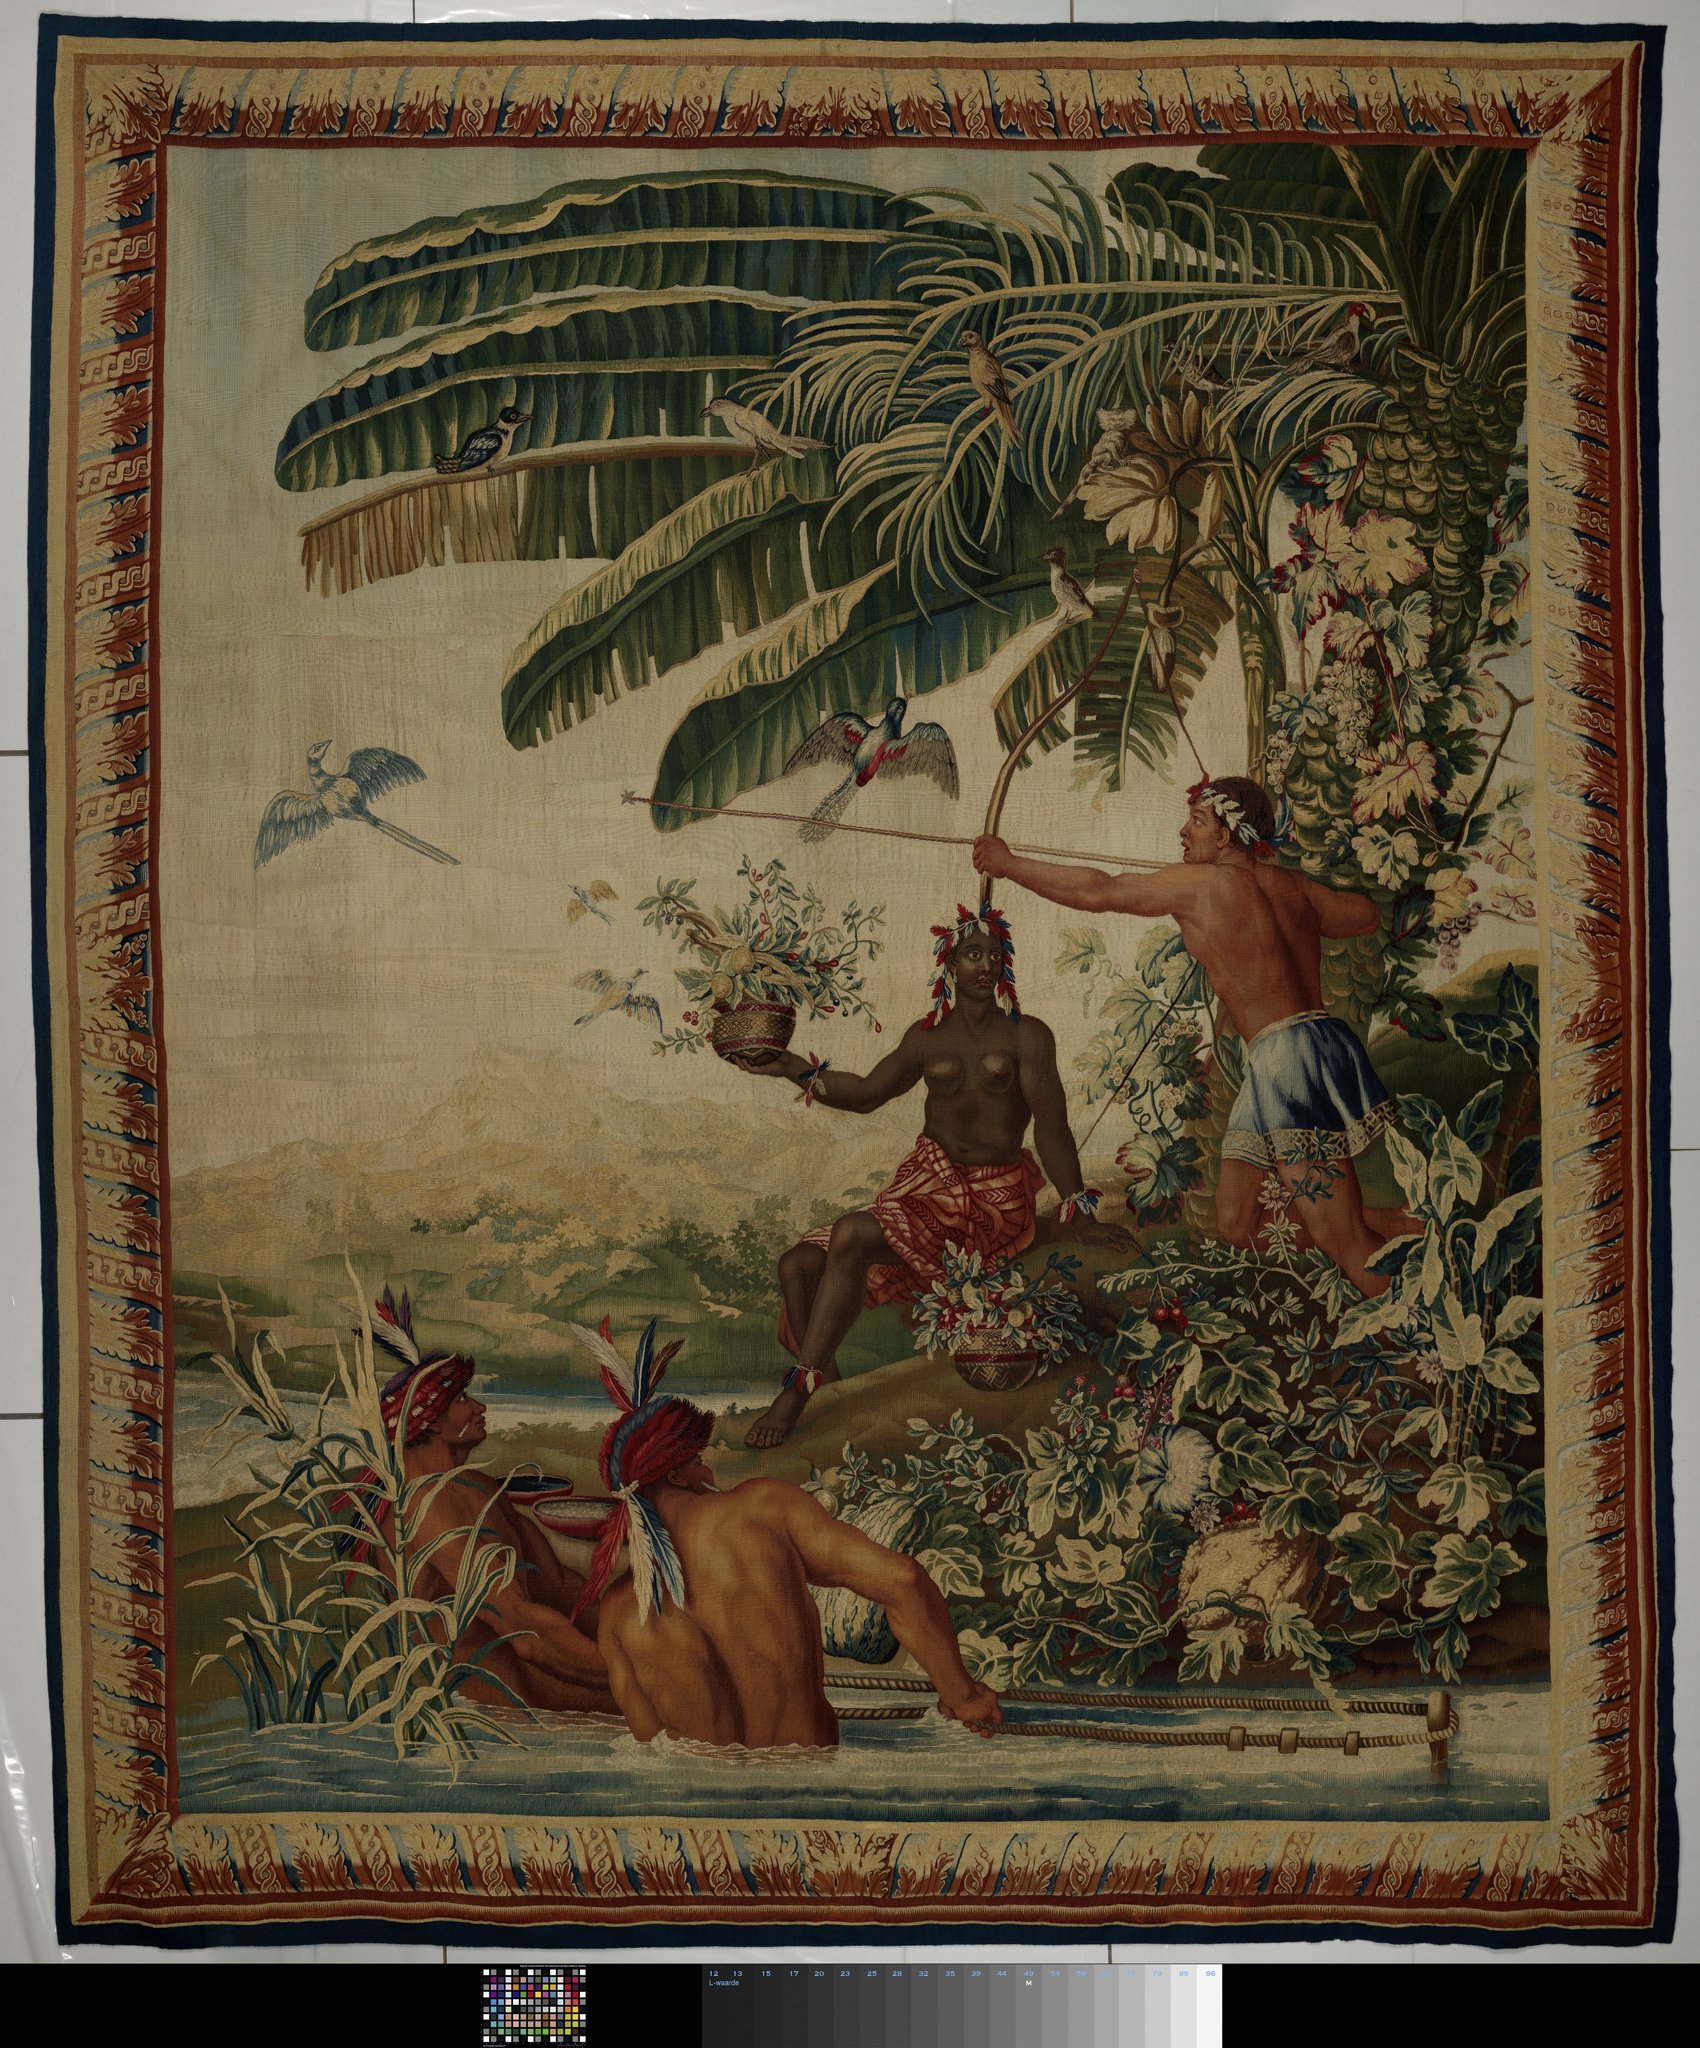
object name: tapestry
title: Fishermen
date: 1692-1723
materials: silk, wool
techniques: tapestry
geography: paris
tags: africans, indigenous peoples of south america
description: The hunter and fishermen depicted here reference the original inhabitants of the Amazon region. In the centre is a woman of African descent. All of the figures are depicted as stereotypes. This tapestry is part of a commissioned series designed for Johan Maurits, who served as governor of the former Dutch Brazil. Upon returning home, he decorated his Mauritshuis with them. He donated the designs to the French king Louis XIV.